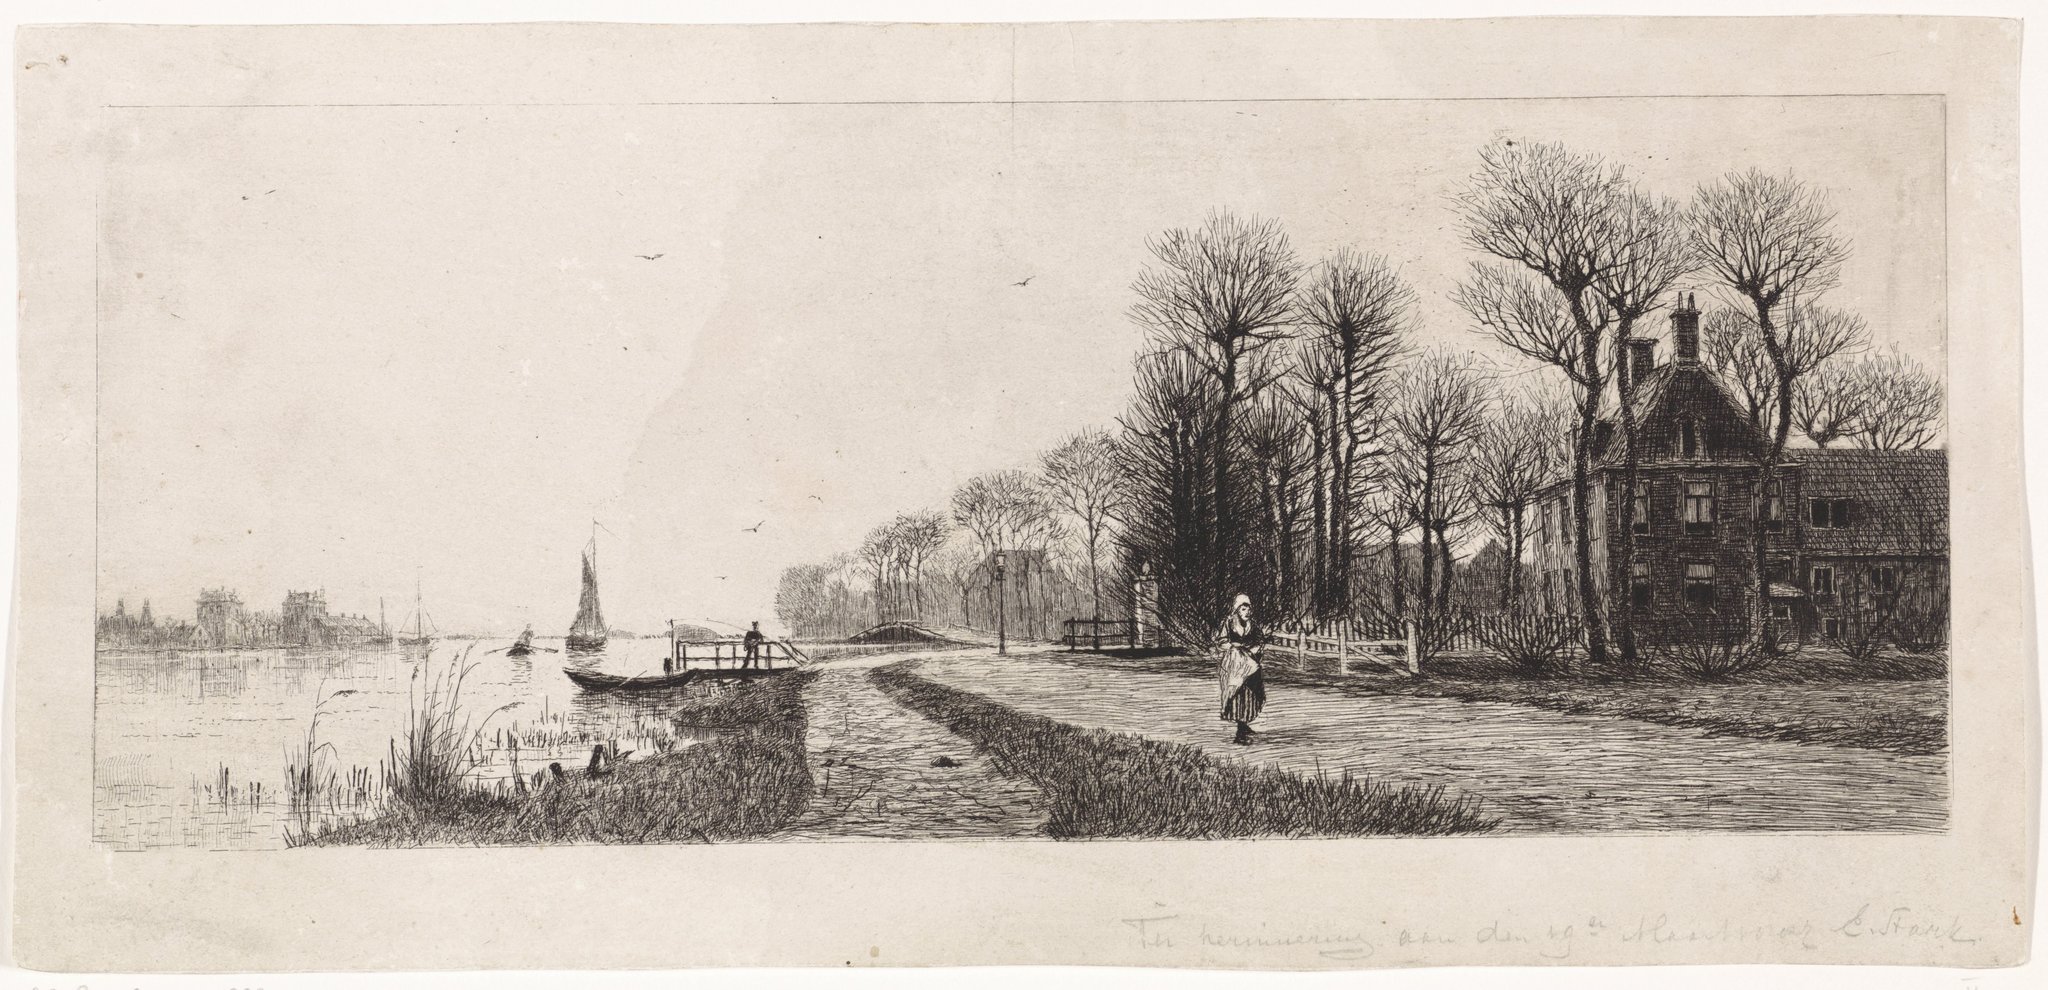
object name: print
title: Huizen aan de Amstel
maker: elias stark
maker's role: draughtsman, print maker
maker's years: 1849-1933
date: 1803-1887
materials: paper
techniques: aquatint, etching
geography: nieuwer-amstel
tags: river (+ landscape with figures, staffage)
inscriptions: collector's mark: Lugt 2228, inscription: ‘Ter herinnering aan den 19en Maart 1887 E. Stark’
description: Huizen langs de rivier de Amstel. Op de weg loopt een vrouw.